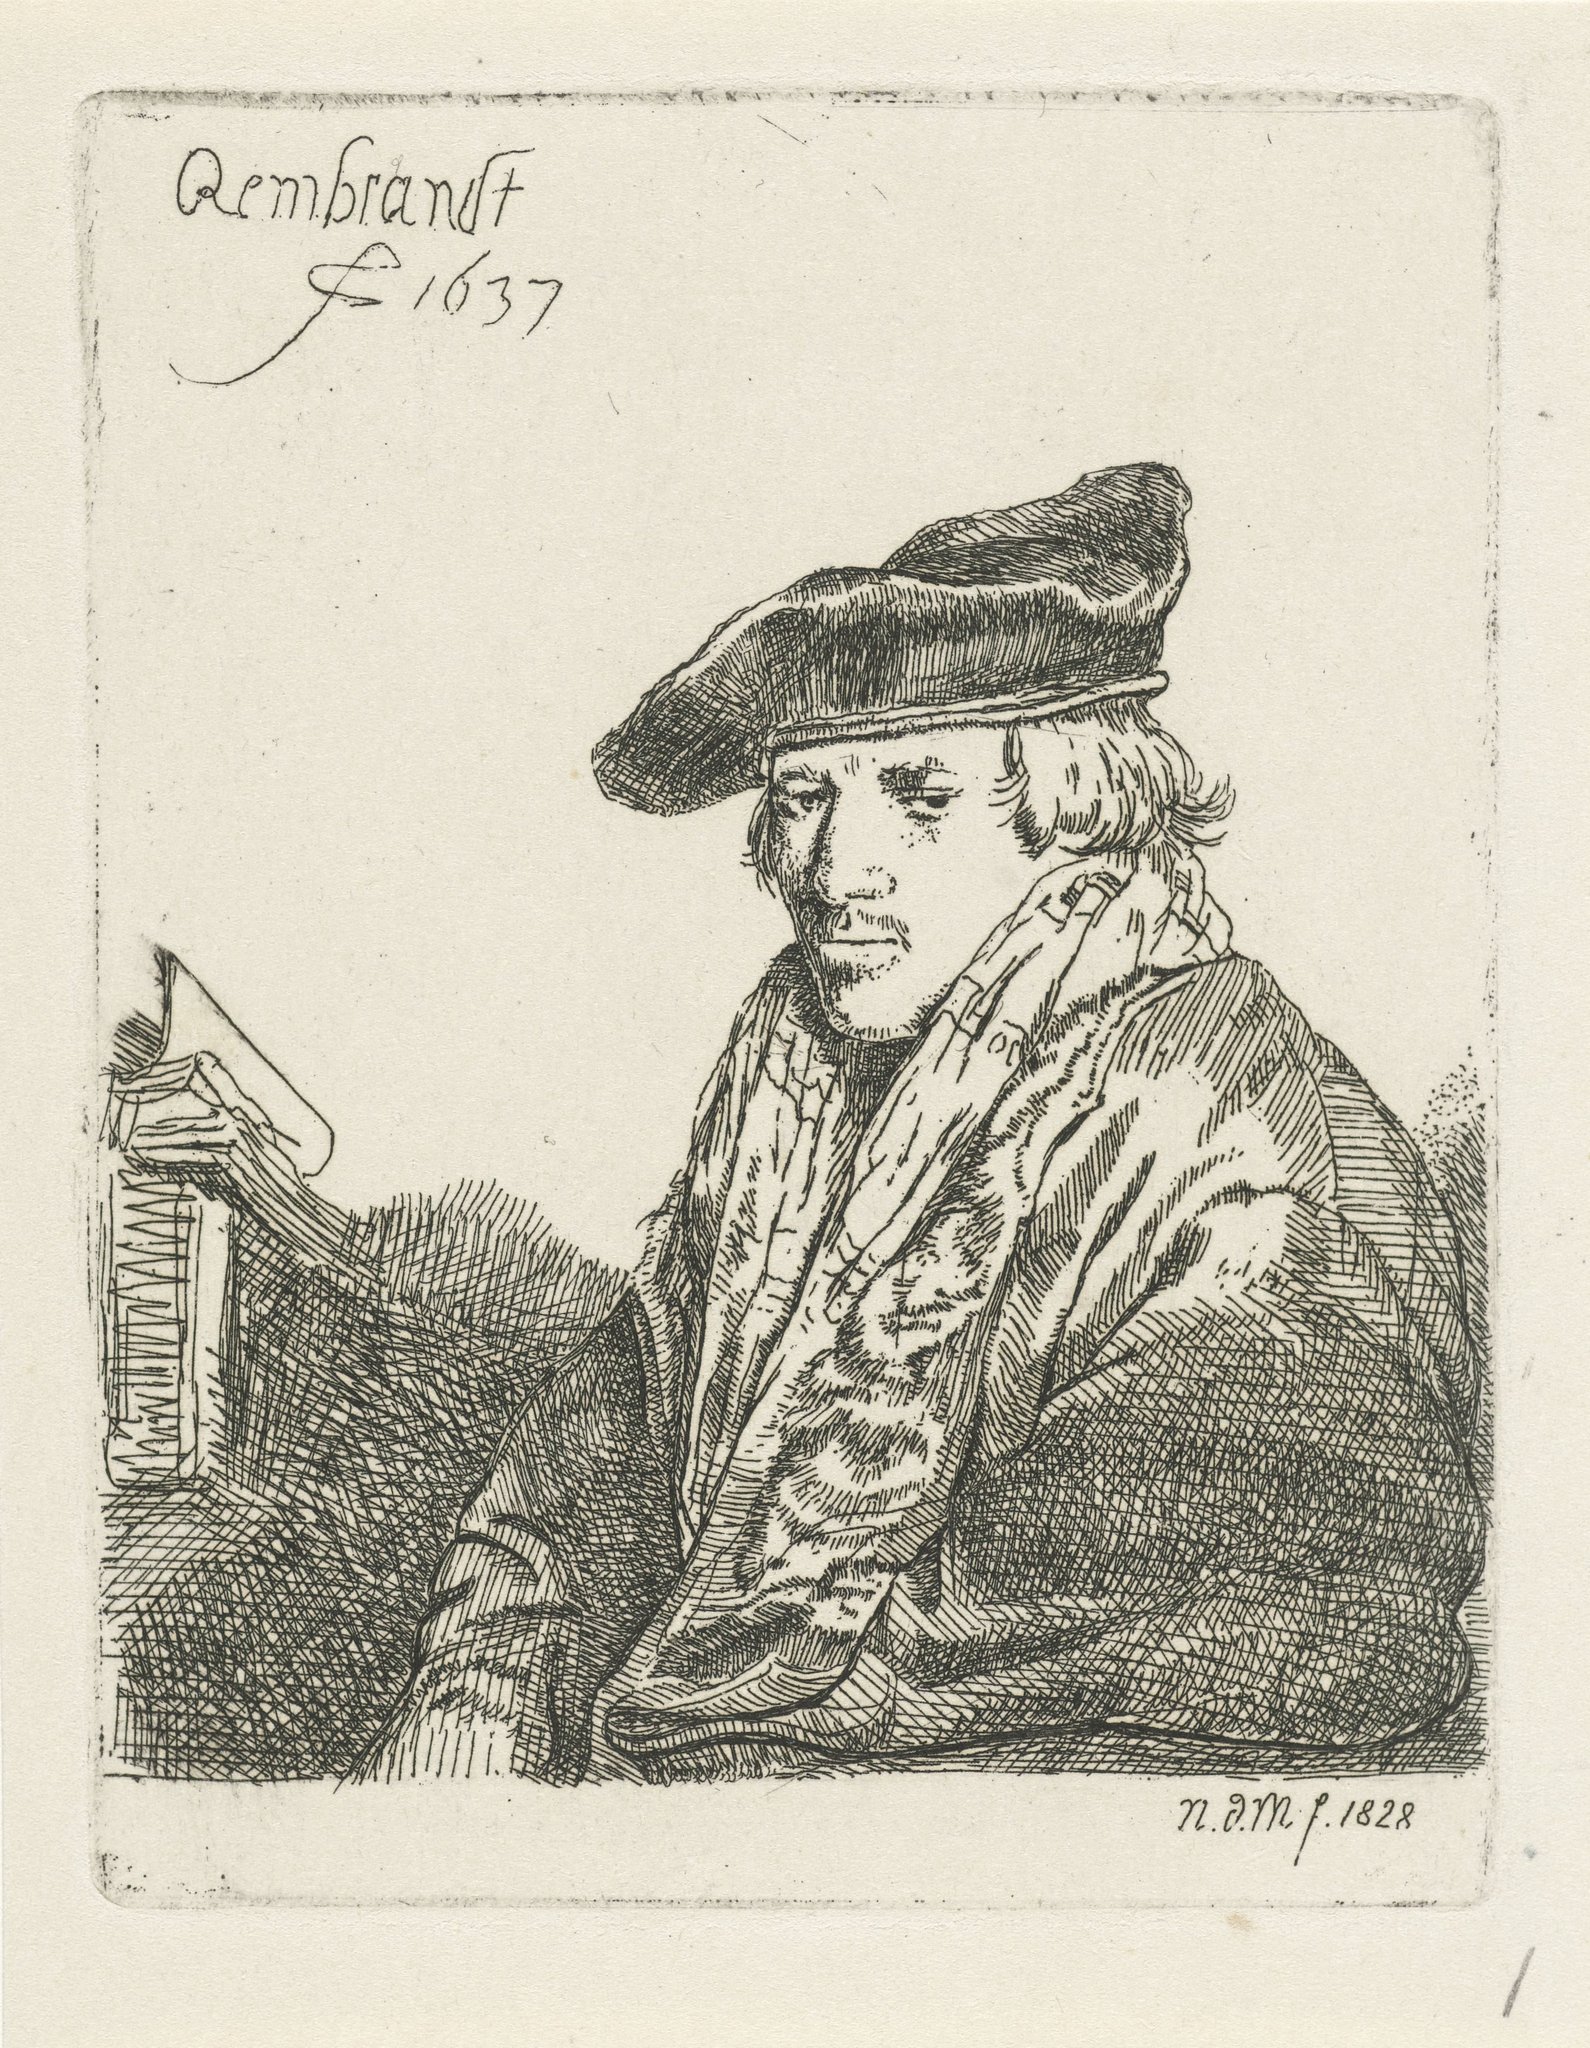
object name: print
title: Jongeman met muts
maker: rembrandt van rijn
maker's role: draughtsman, painter, print maker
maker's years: 1606-1669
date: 1828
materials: paper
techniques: etching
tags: head-gear: cap (+ men's clothes)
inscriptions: collector's mark: Lugt 2228